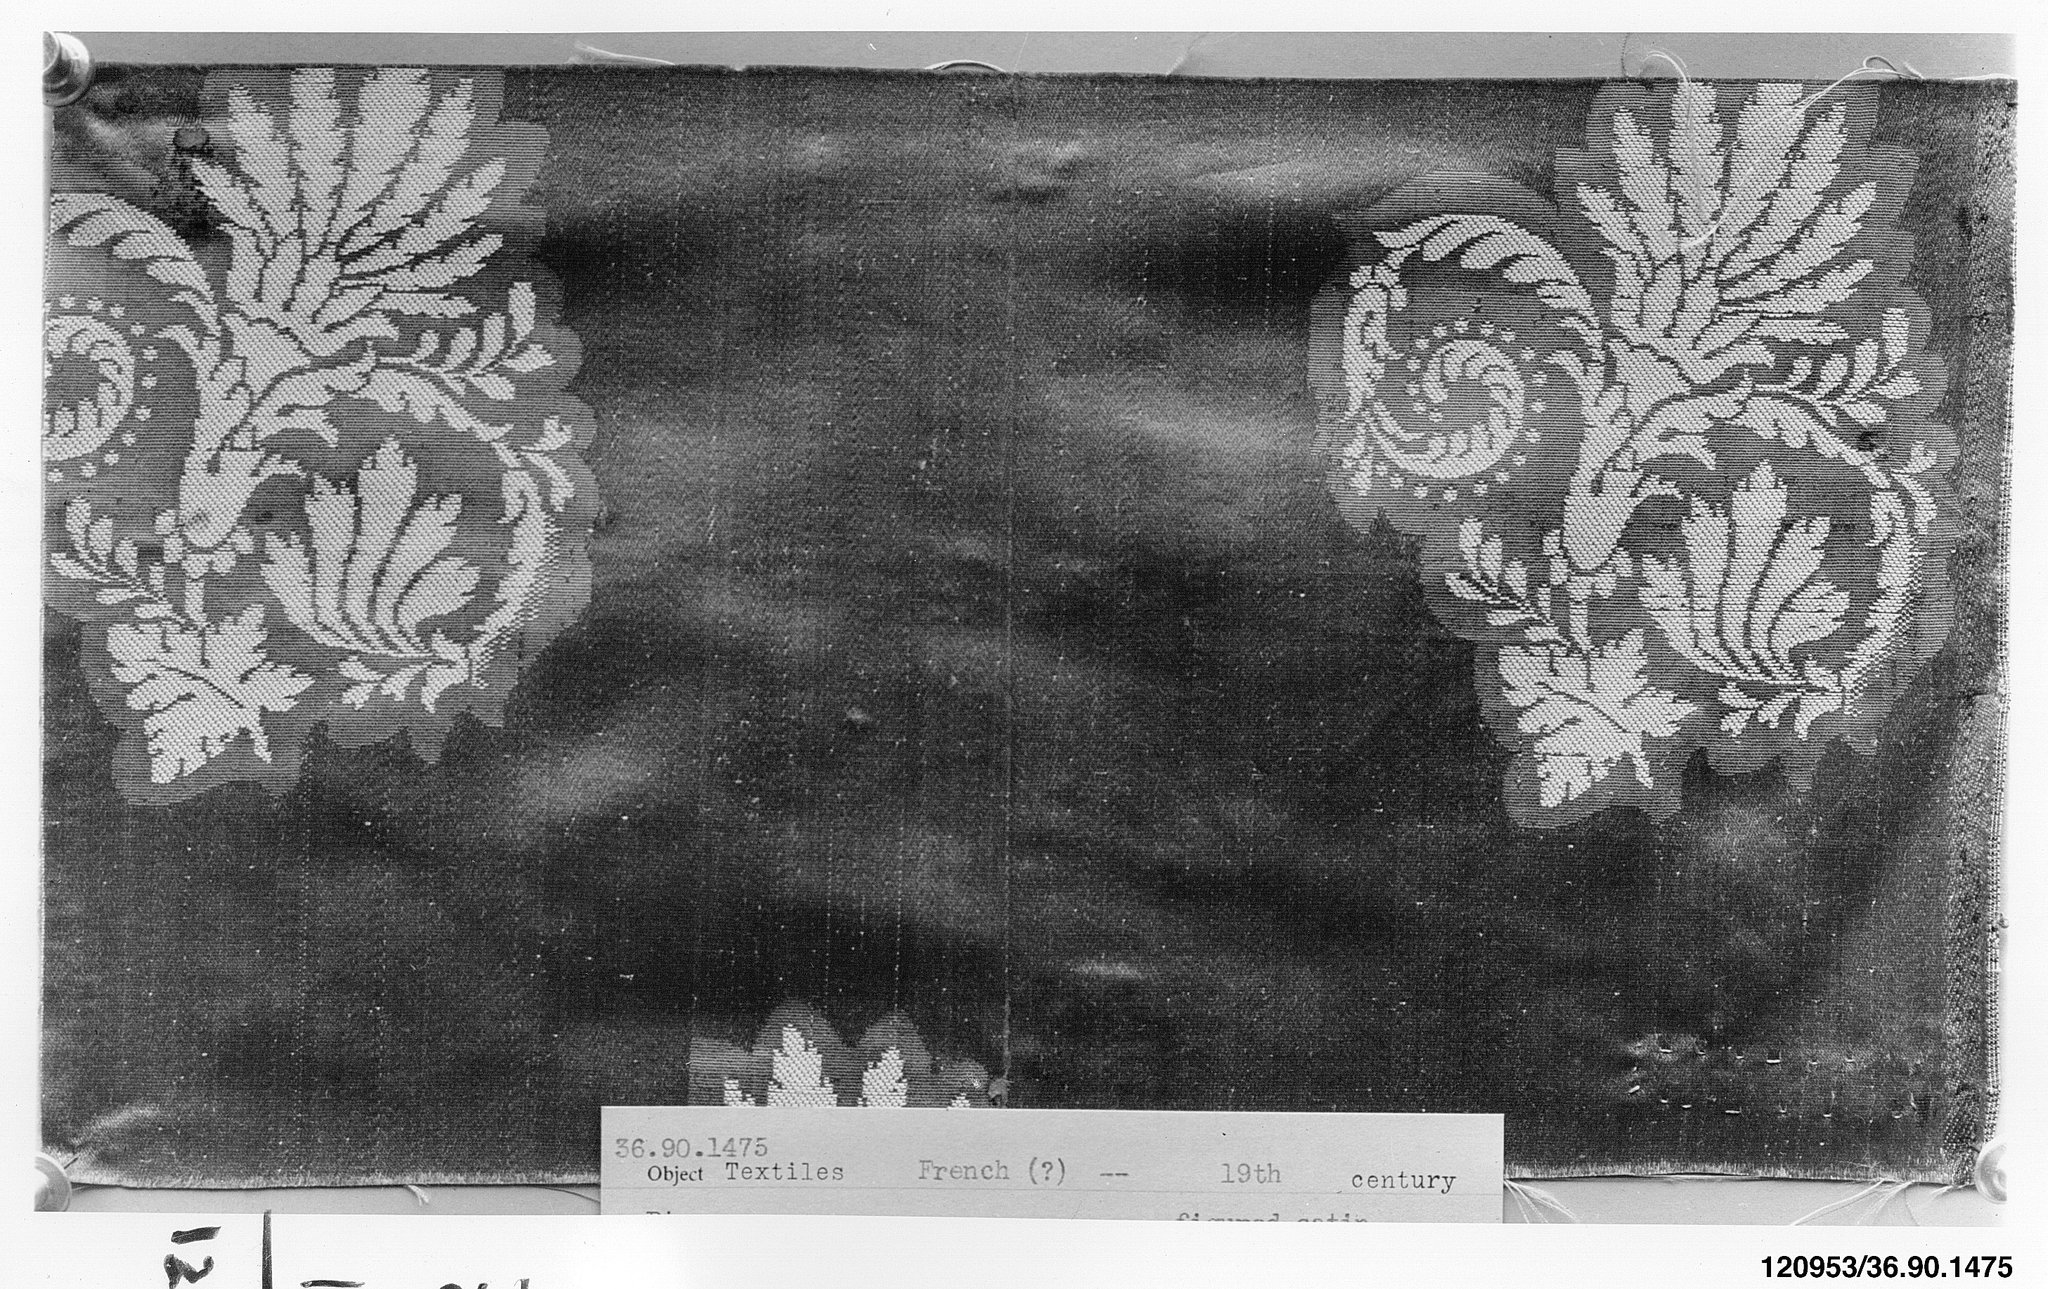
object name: piece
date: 1801-1900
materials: silk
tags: leaves